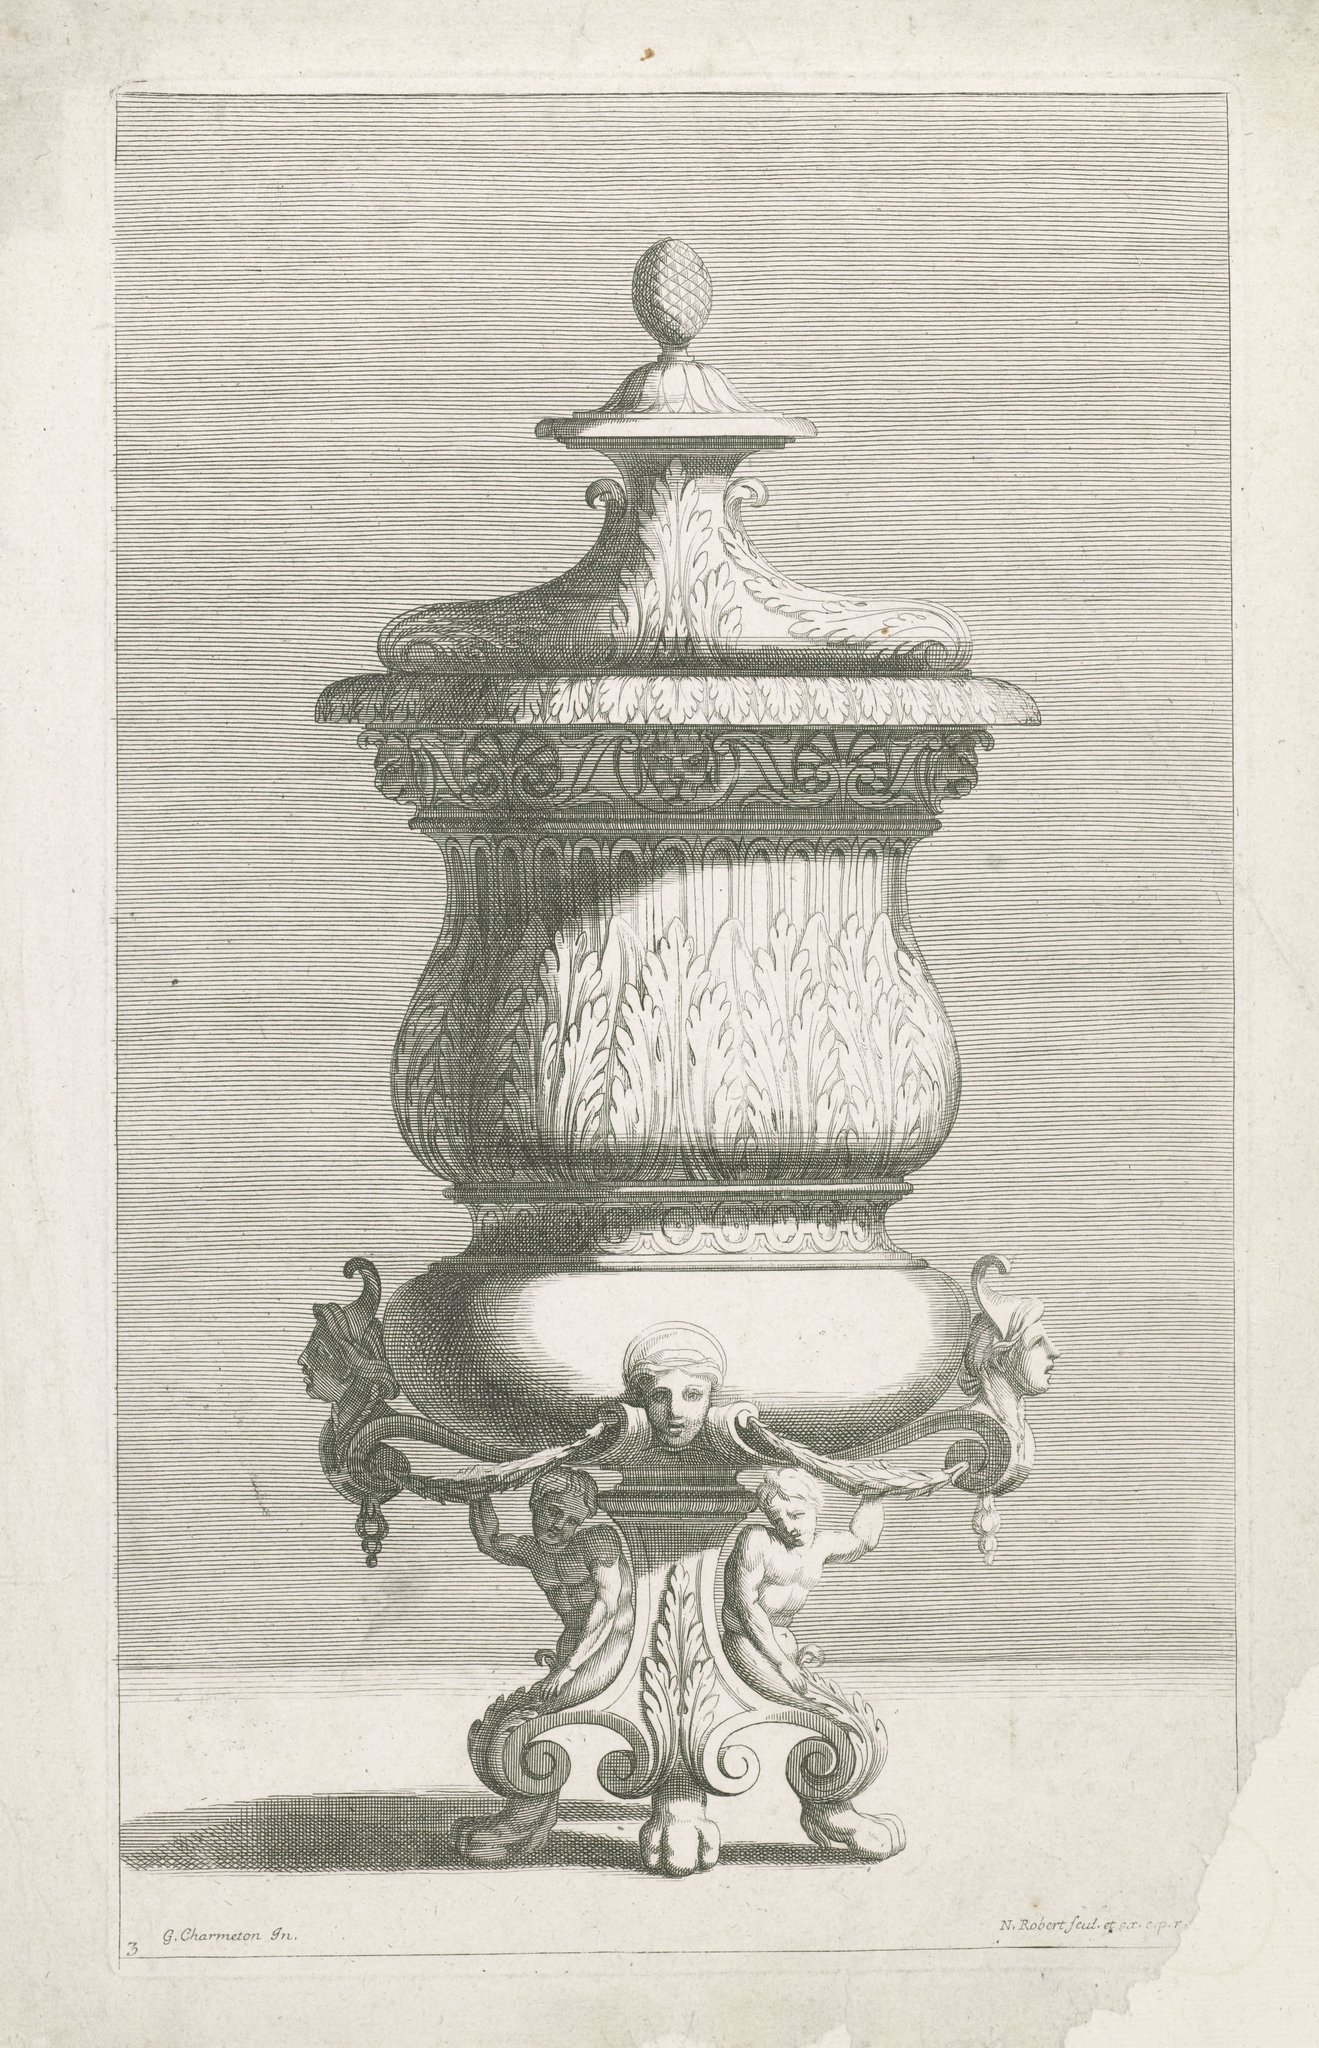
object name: ornament print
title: Plusieurs Vaze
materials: paper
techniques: engraving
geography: france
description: Het lichaam van de vaas is gedecoreerd met acanthusbladeren, de balustervormige voet rust op consoles ondersteund door klauwen, waarop twee hermen zitten. Blad 3 uit serie van 6 bladen met vazen en urnen.